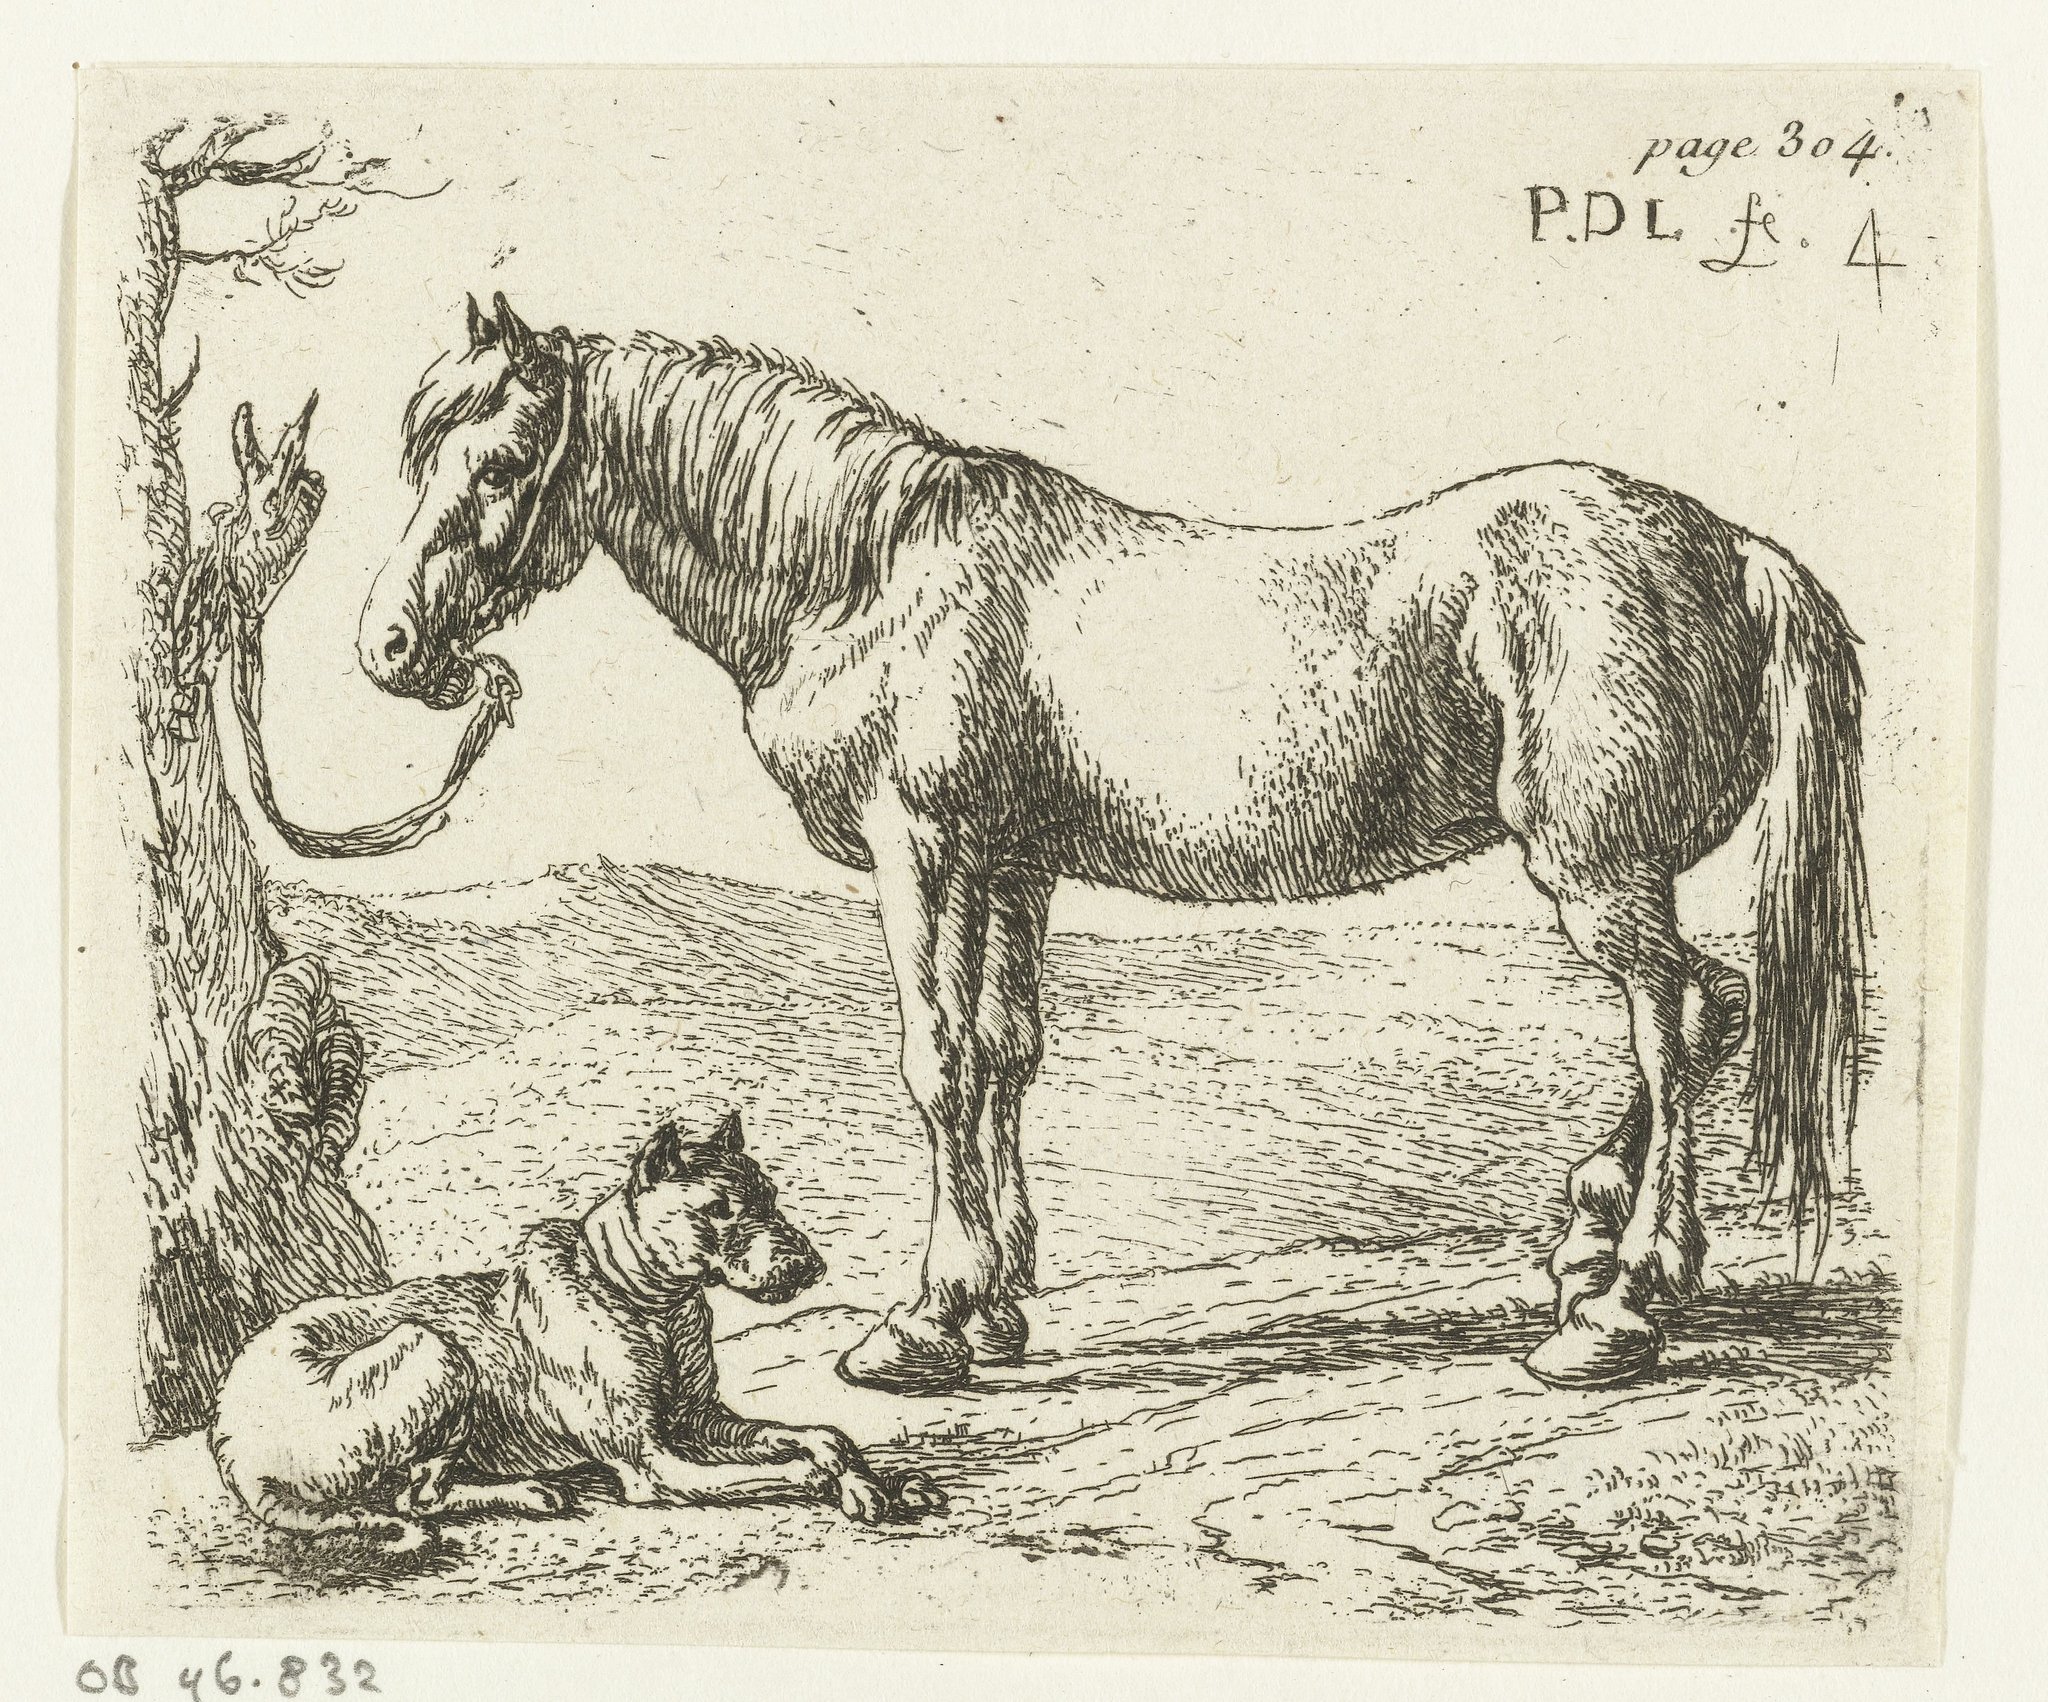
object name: print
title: Paarden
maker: pieter bodding van laer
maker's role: draughtsman, painter, print maker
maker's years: 1599-1642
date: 1609-1642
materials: paper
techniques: etching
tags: horse, dog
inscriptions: collector's mark: Lugt 2228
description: Een paard staat, met de teugels vastgemaakt aan een boom, in een weide. Links ligt een hond. Prent rechtsboven gemerkt: page 304. Op de voorgrond ligt een hond. De prent maakt deel uit van een zesdelige serie met voorstellingen van paarden.